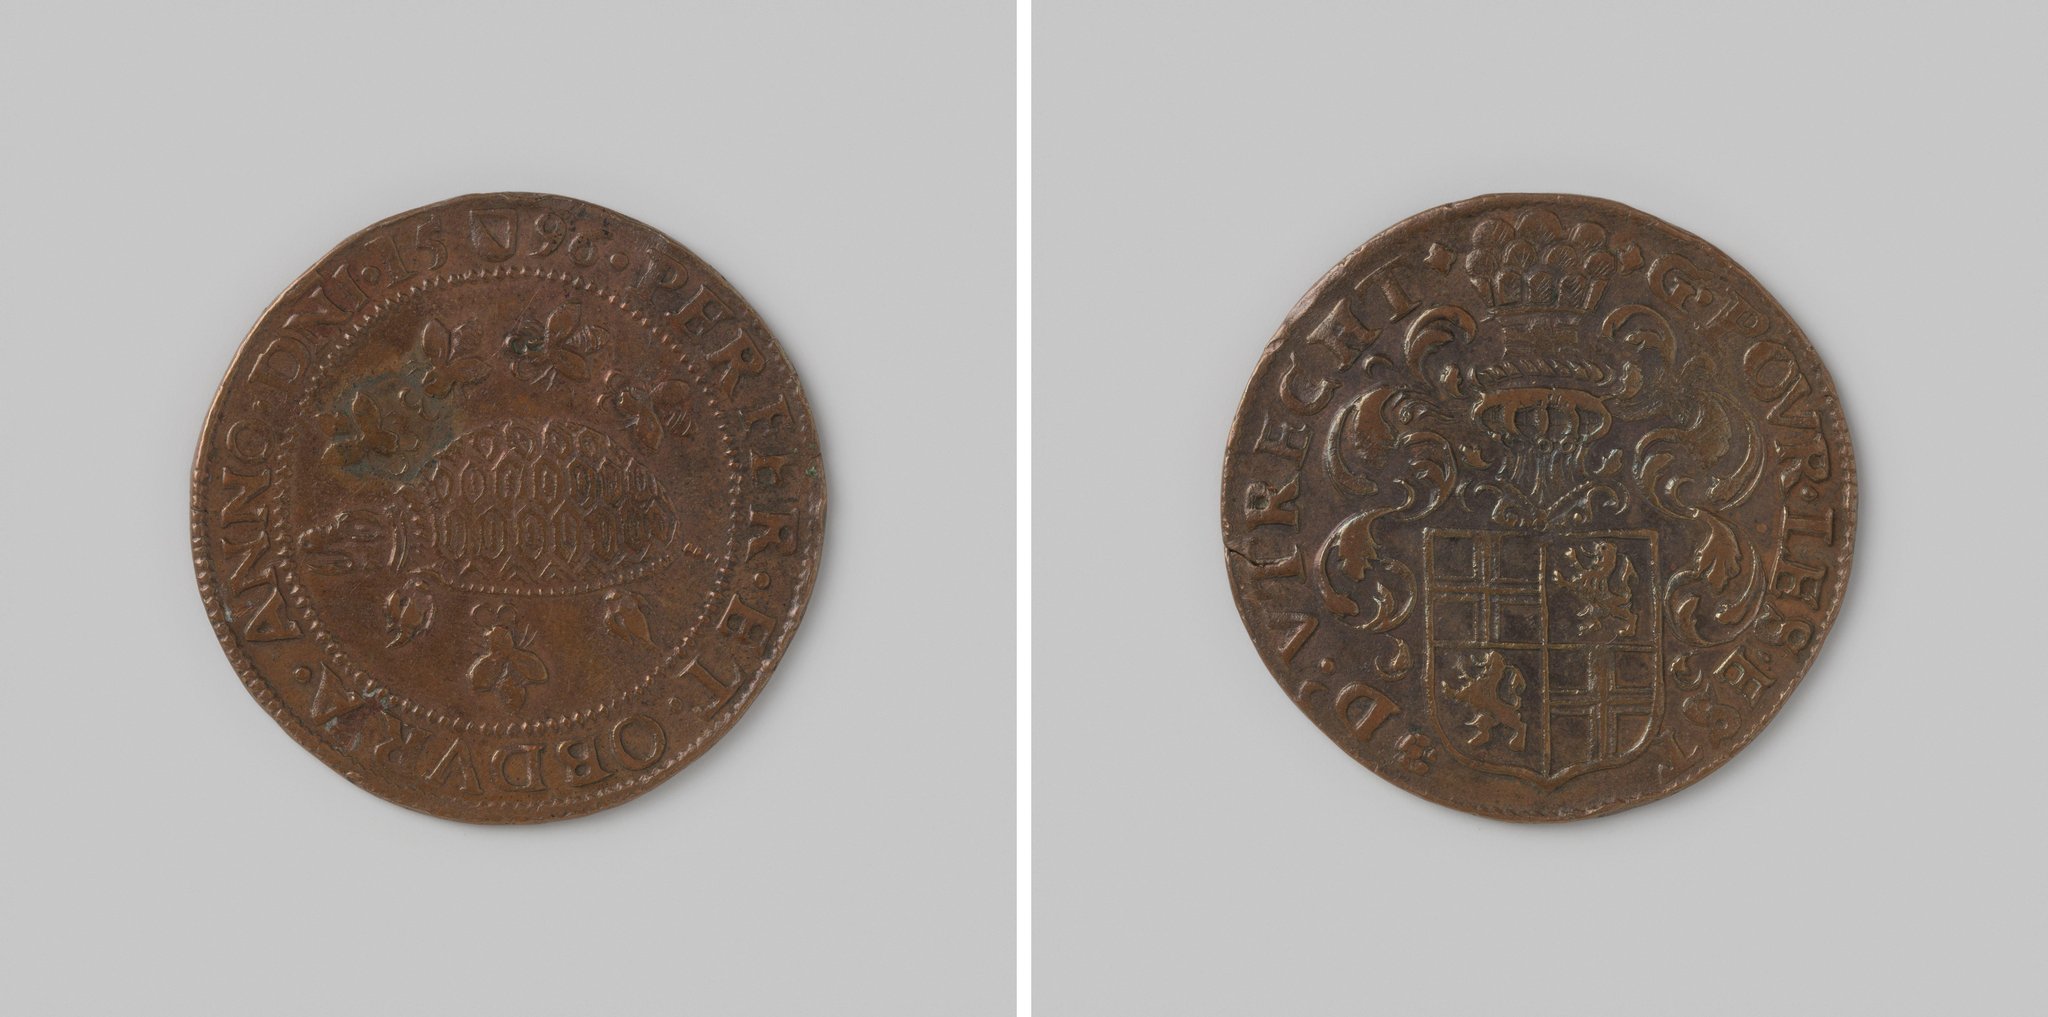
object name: history medal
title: Rekenpenning uit Utrecht voor de Staten van Utrecht op de drukkende lasten 1596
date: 1596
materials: copper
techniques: striking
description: Koperen penning, op de voorzijde een schildpad tussen bijen, met omschrift, op de keerzijde het gehelmde wapenschild van de provincie Utrecht, met omschrift.